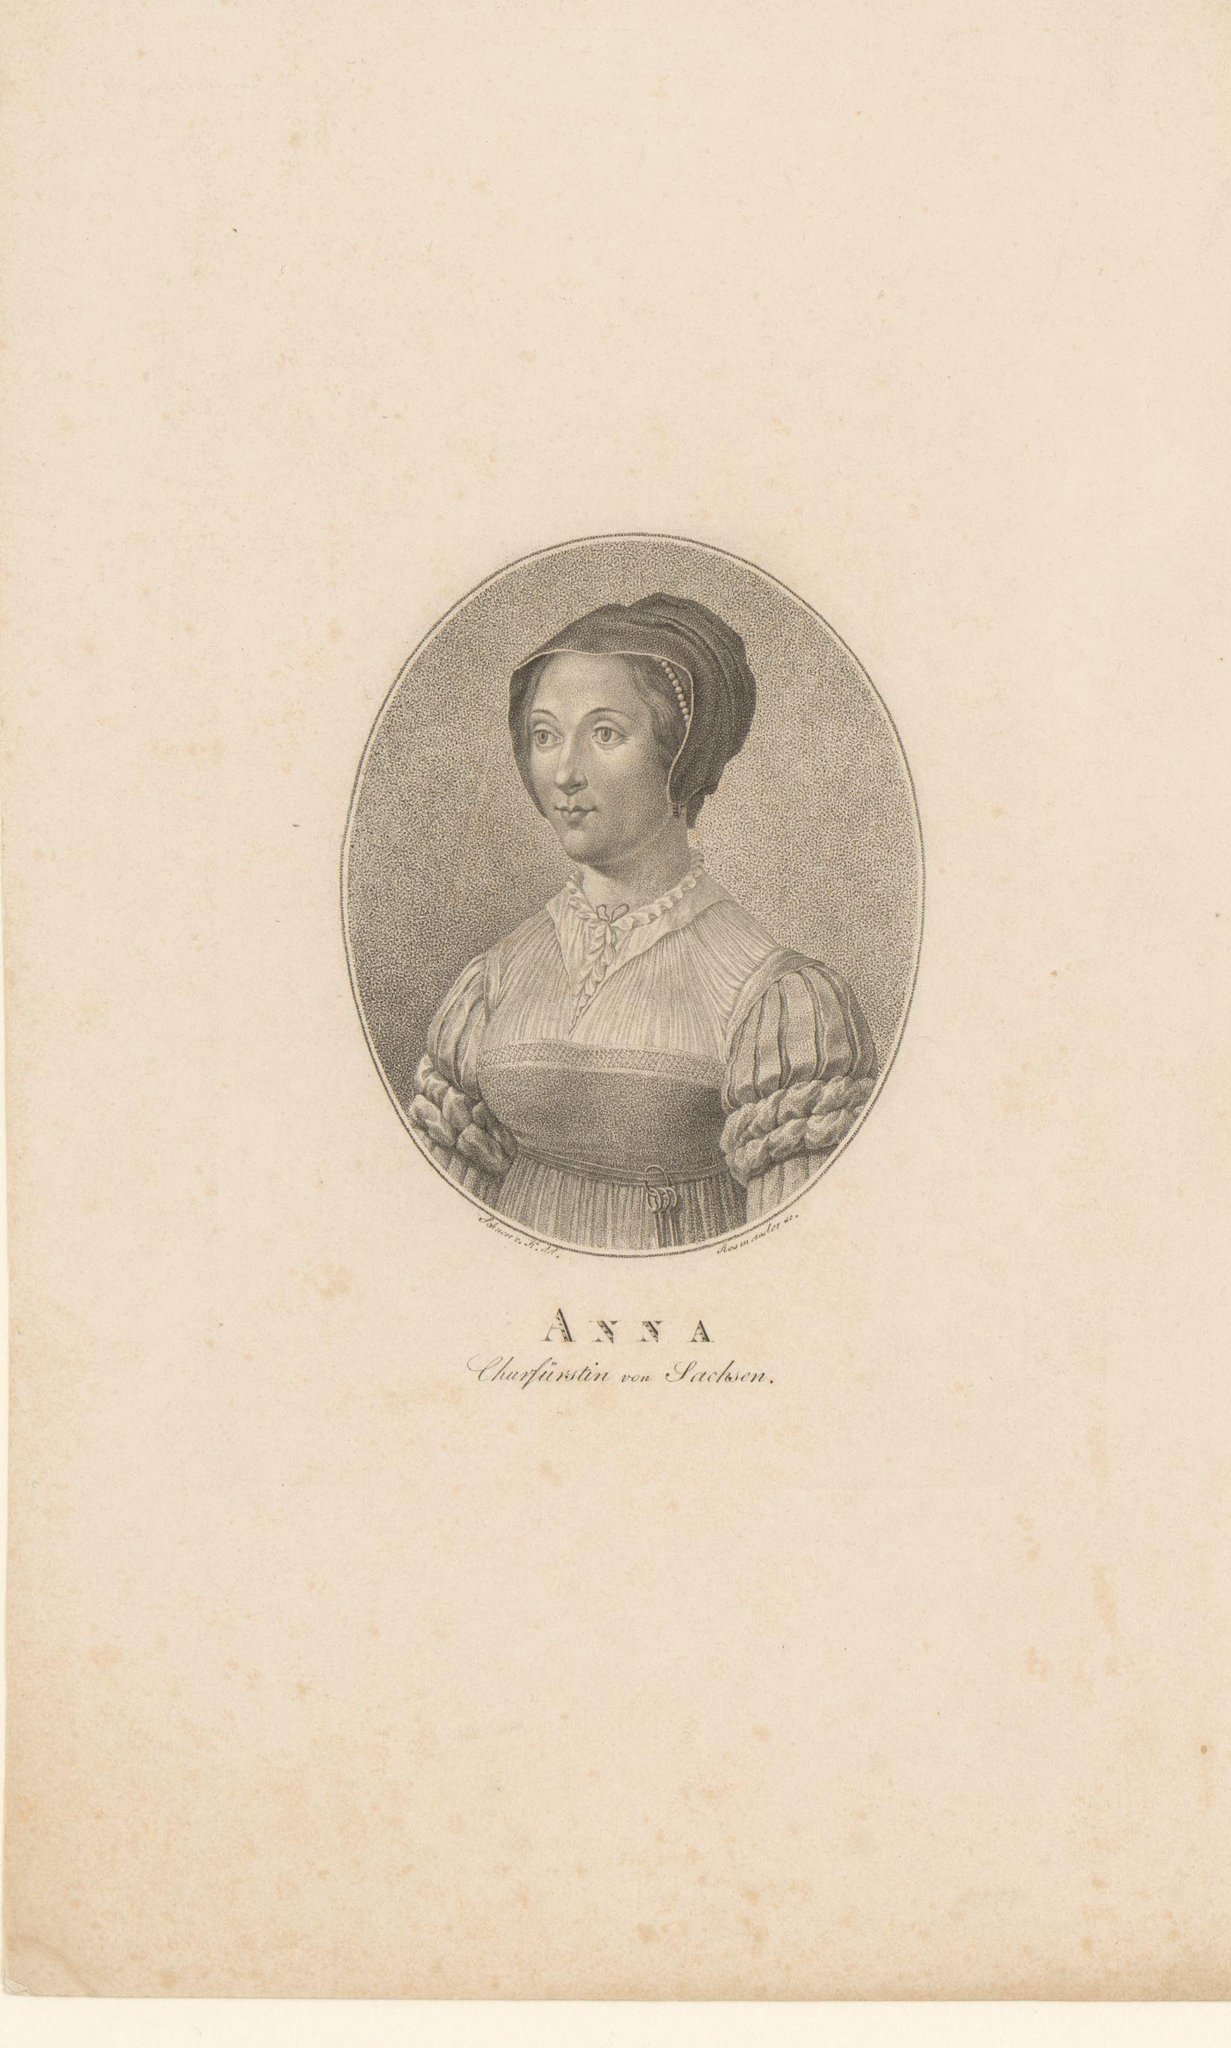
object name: print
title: Portret van Anna van Saksen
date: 1785-1858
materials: paper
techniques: engraving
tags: historical persons - bb - woman, key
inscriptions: collector's mark: Lugt 2228